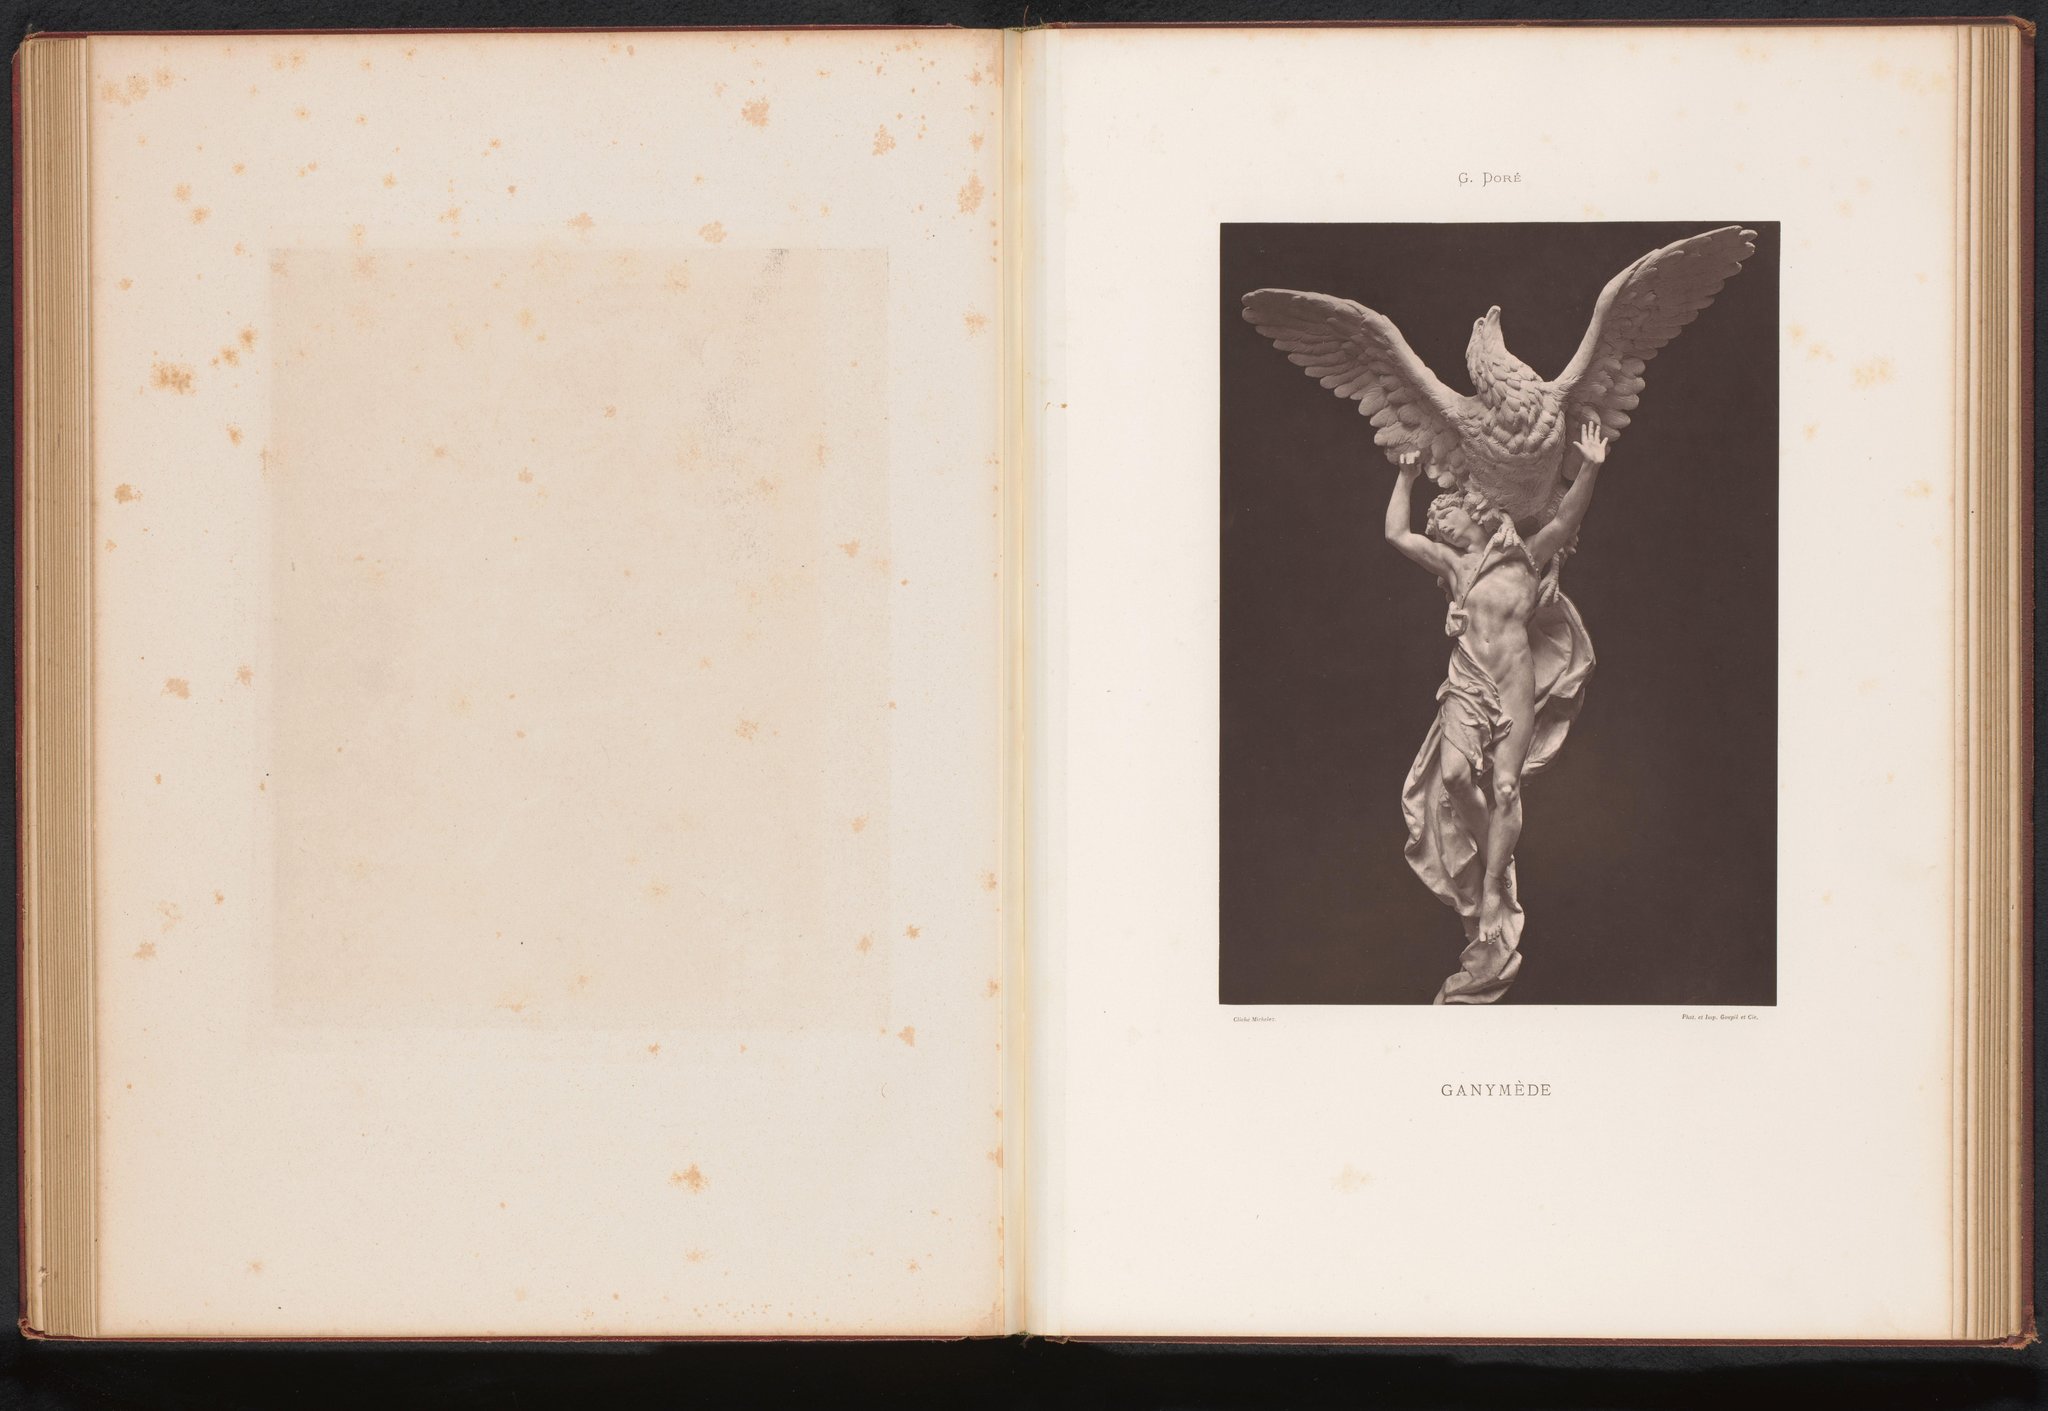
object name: photomechanical print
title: Ganymède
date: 1874-1879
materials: paper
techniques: woodburytype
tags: the rape of ganymede: he is carried off through the air by jupiter in the form of an eagle, or by the eagle of jupiter, sculpture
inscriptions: name: ‘G. Doré’